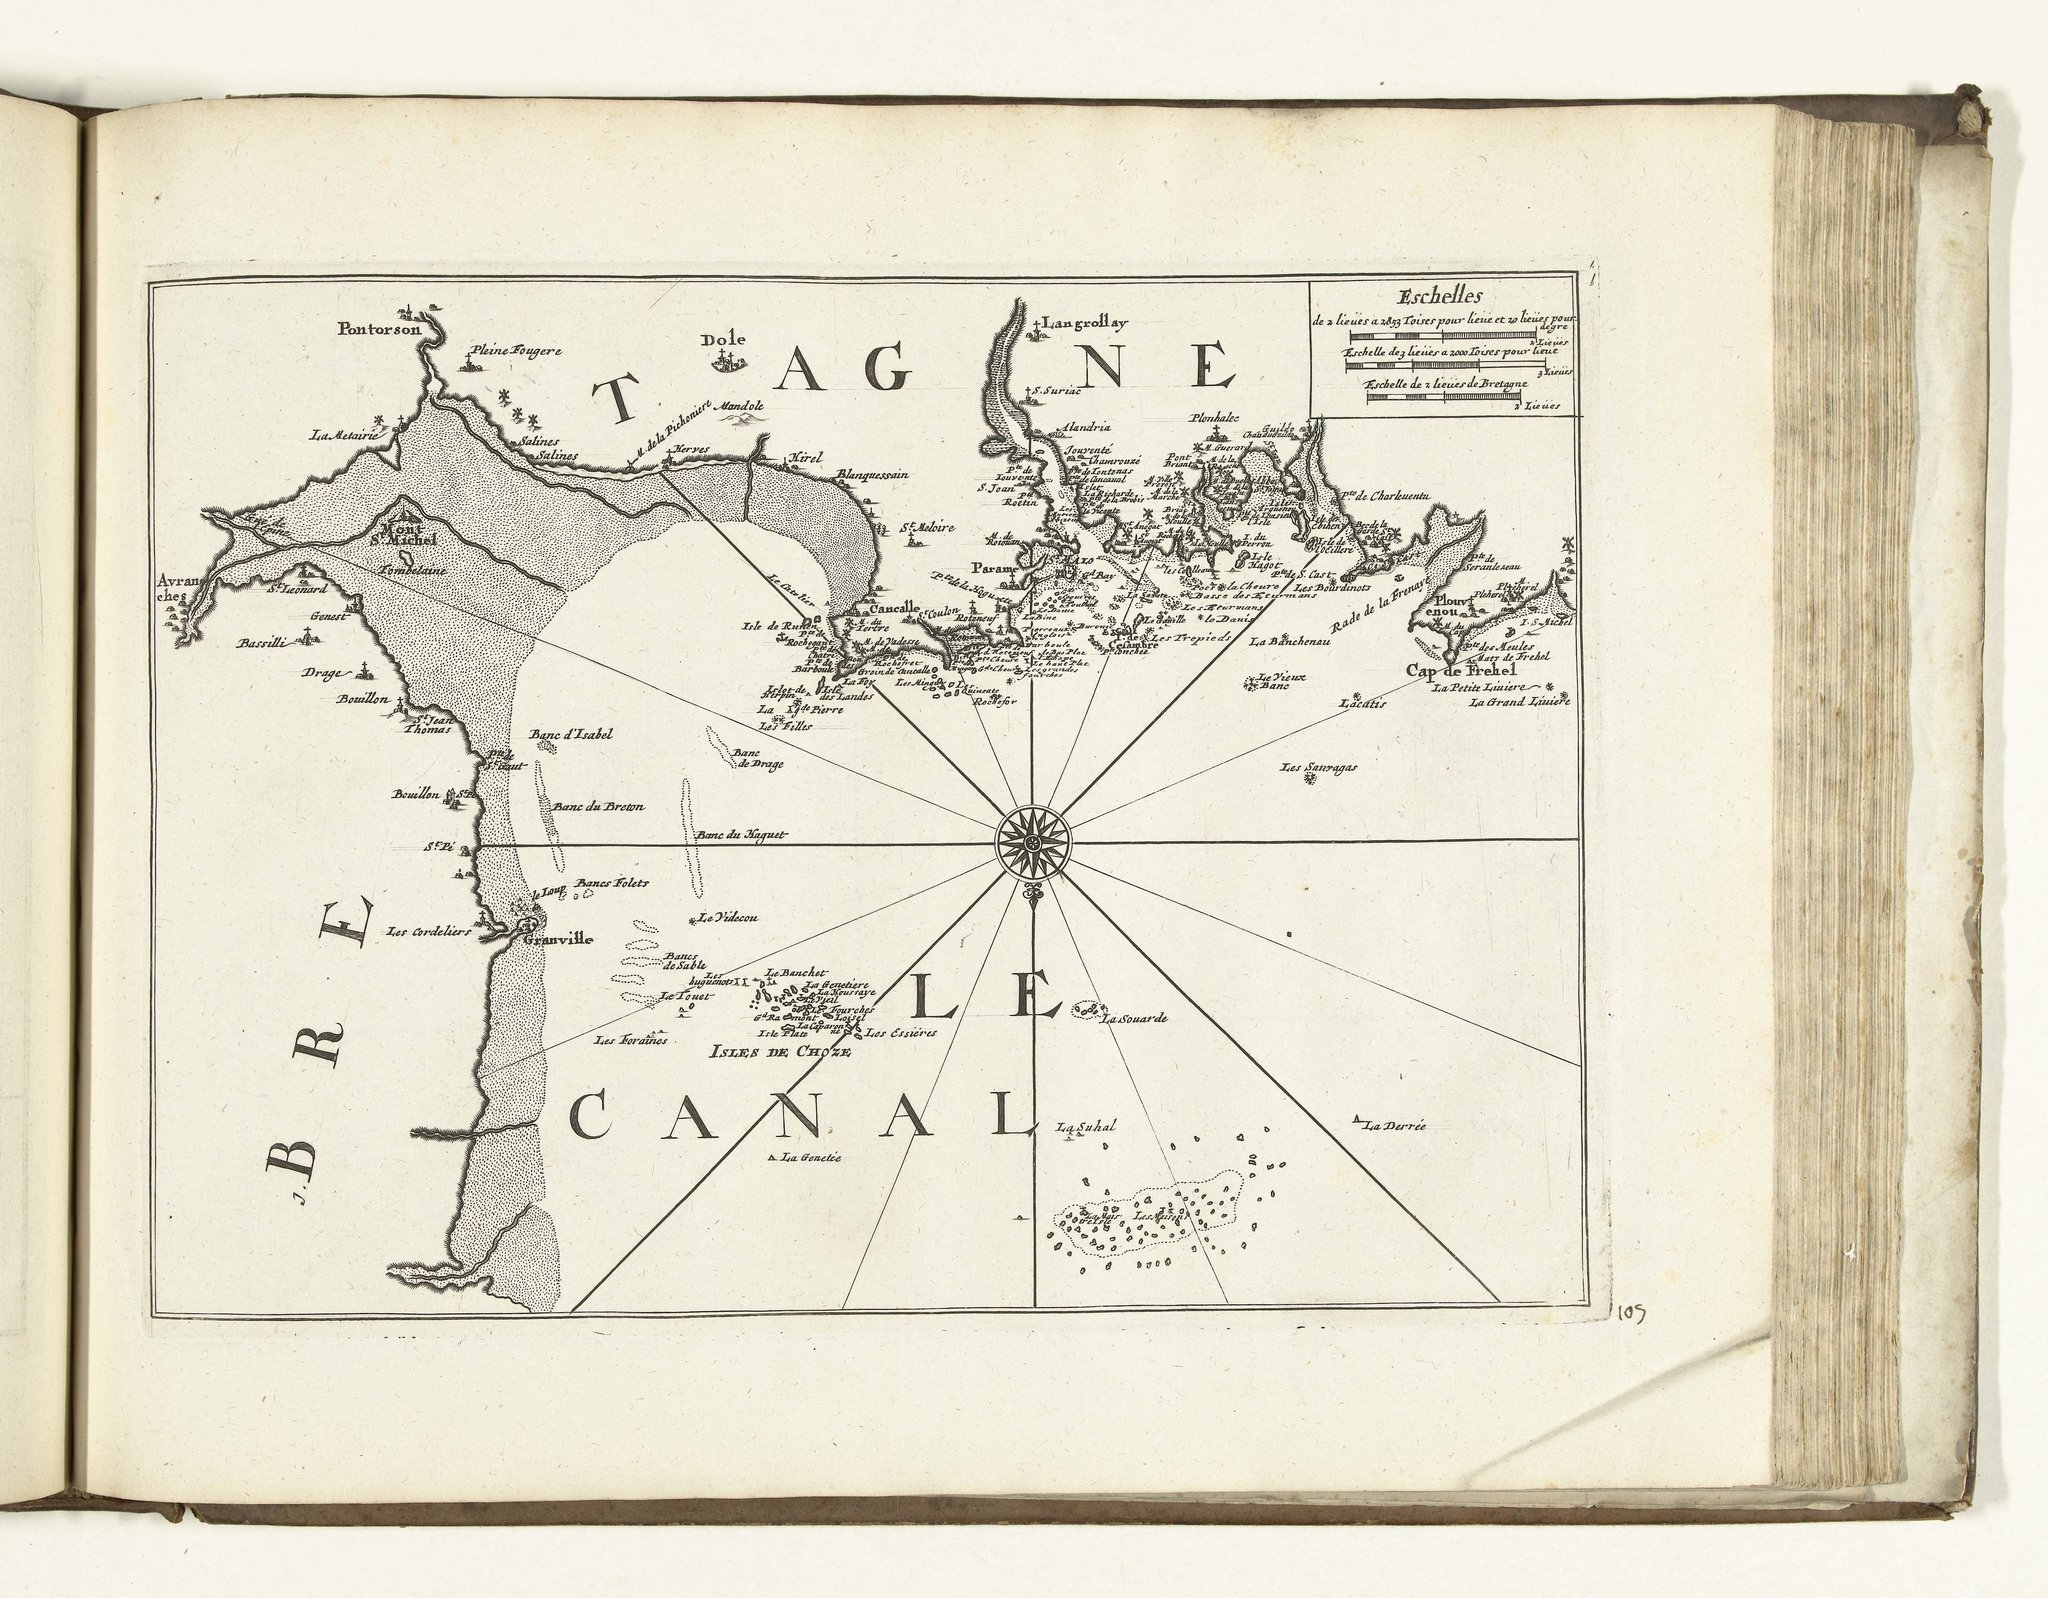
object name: print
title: Kaart van de Franse kust bij Mont-Saint-Michel, 1726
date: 1726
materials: paper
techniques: engraving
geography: leiden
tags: maps of separate countries or regions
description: Kaart van de Franse kust bij Mont-Saint-Michel. Plaat nr. 107 in deel V van het prentwerk: Les Forces de l'Europe, Asie, Afrique et Amerique ... Comme aussi les Cartes des Côtes de France et d'Espagne uit 1726, dit eerste deel met 238 met de hand genummerde platen van vermaarde sterke steden en vestingen in het kader van de Spaanse Successieoorlog 1701-1713. Voor het merendeel zijn deze platen gekopieerd naar de anonieme Franse platen van vermaarde sterke steden en vestingen: in Les forces de l'Europe en in: Le theatre de la guerre, dans les Pays-Bas, beide oorspronkelijk uitgegeven door Nicolas de Fer te Parijs (1693-1697) in het kader van de Negenjarige Oorlog. Opschriften in het Frans.